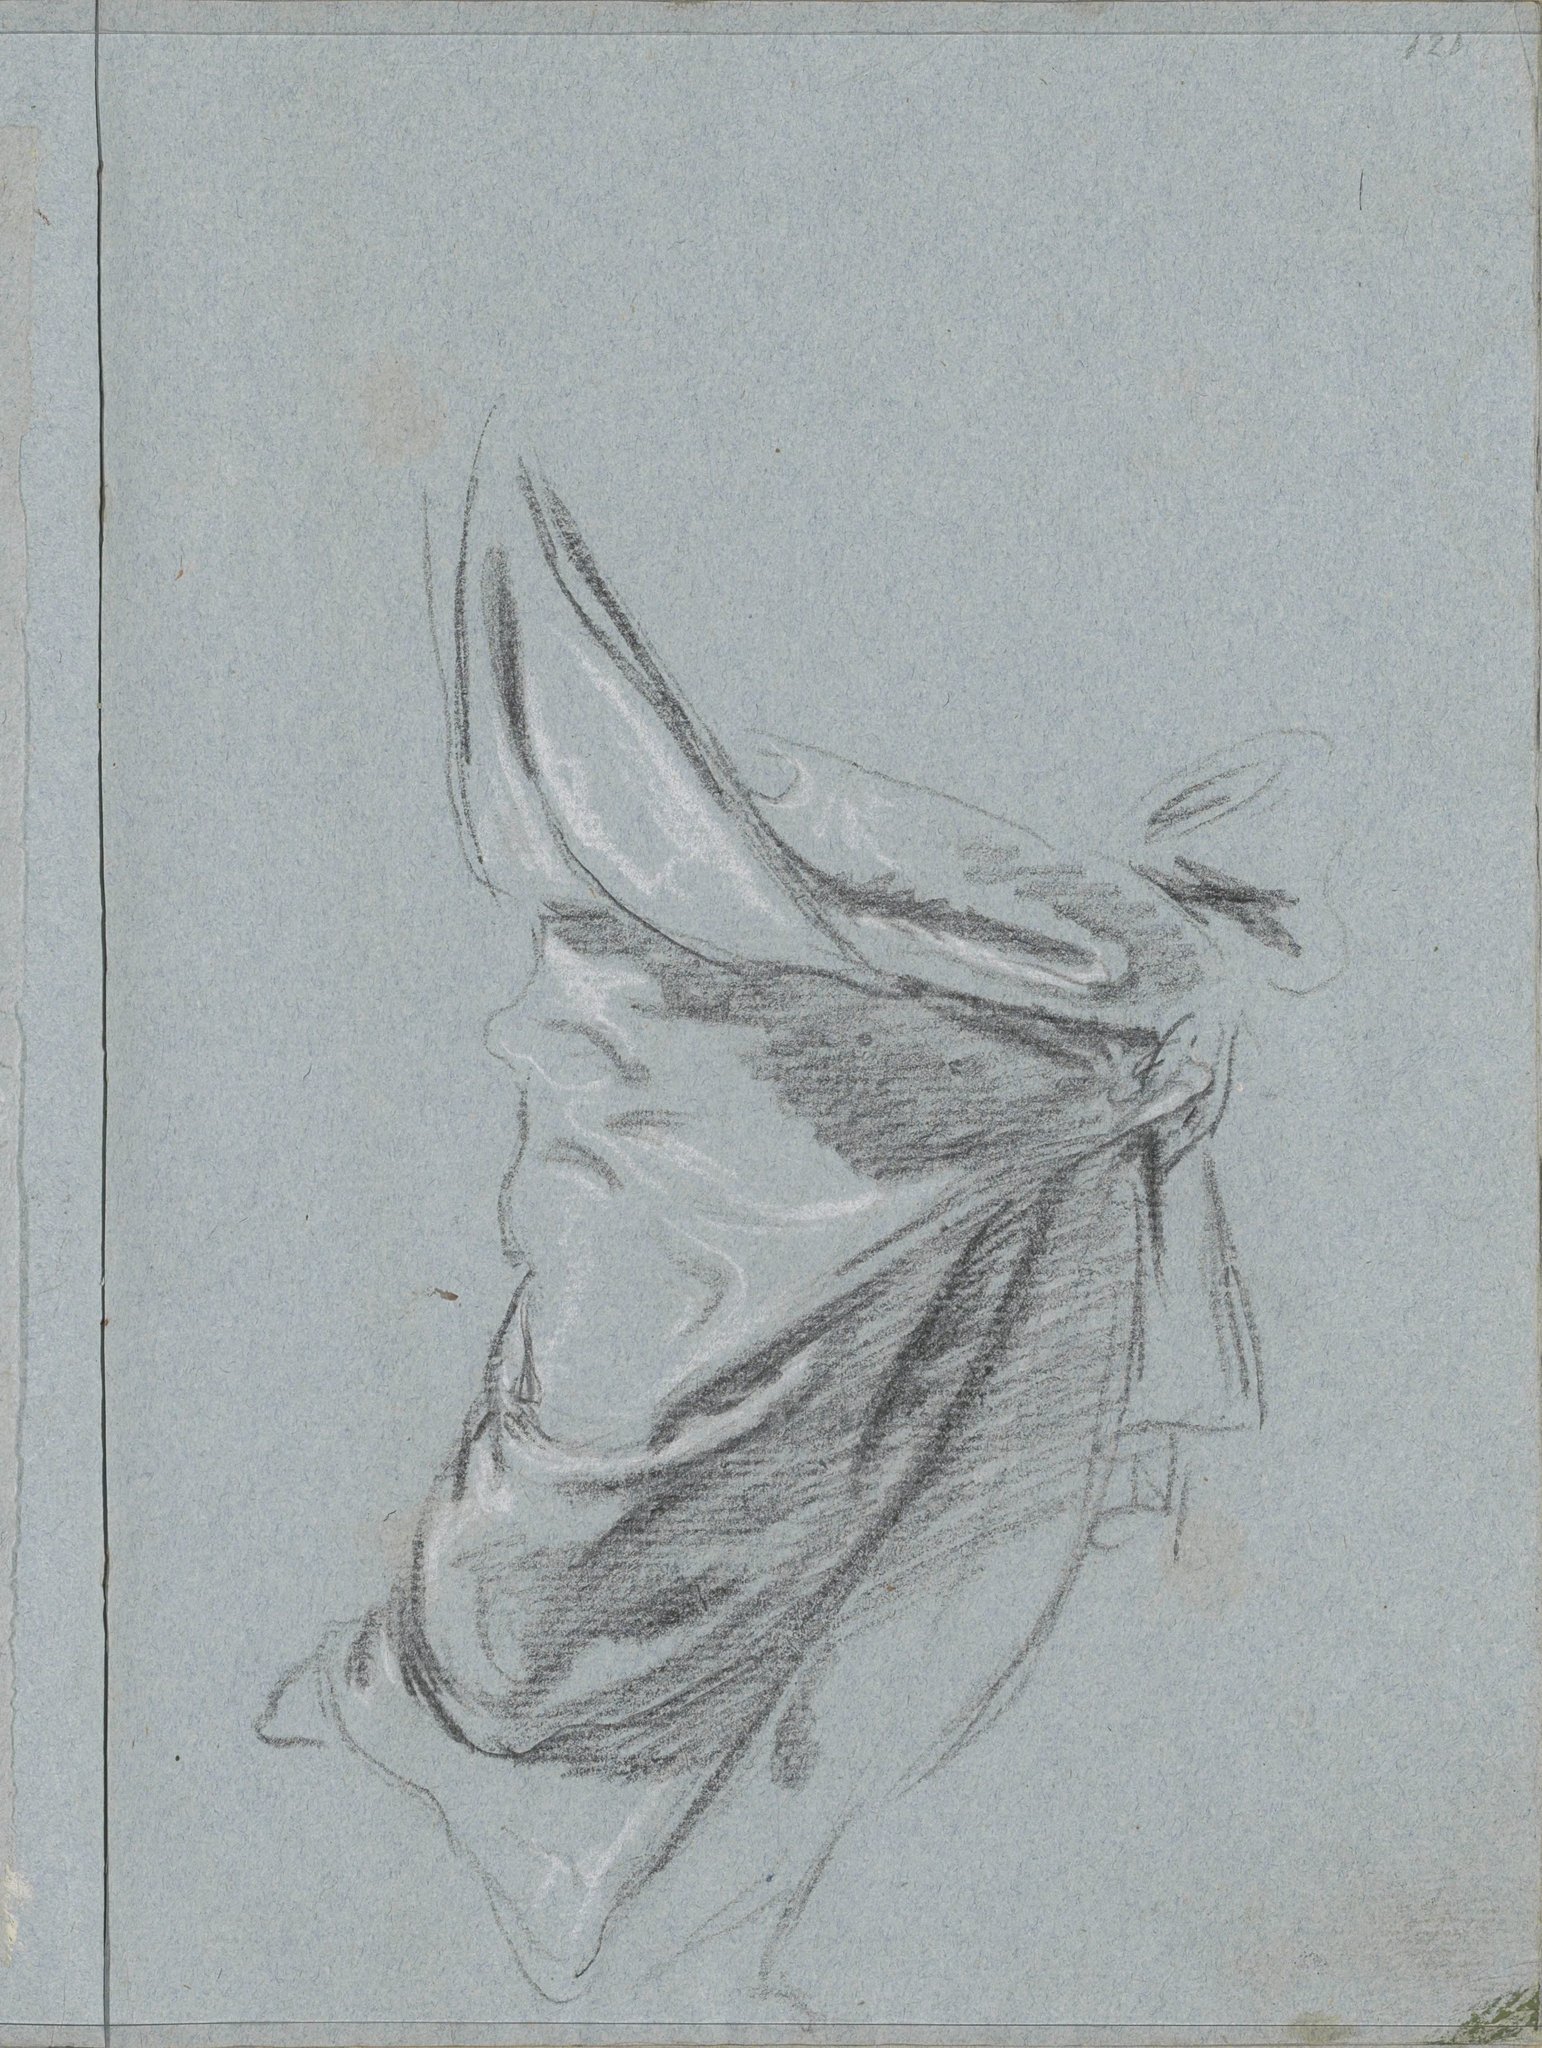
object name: sketchbook leaf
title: Draperie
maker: lorenzo baldissera tiepolo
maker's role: draughtsman, print maker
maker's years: 1736-1776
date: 1751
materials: chalk, paper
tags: drapery, draped garment, 'gewandgebung'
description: Bladzijde 121 uit een schetsboek met 158 bladzijden.